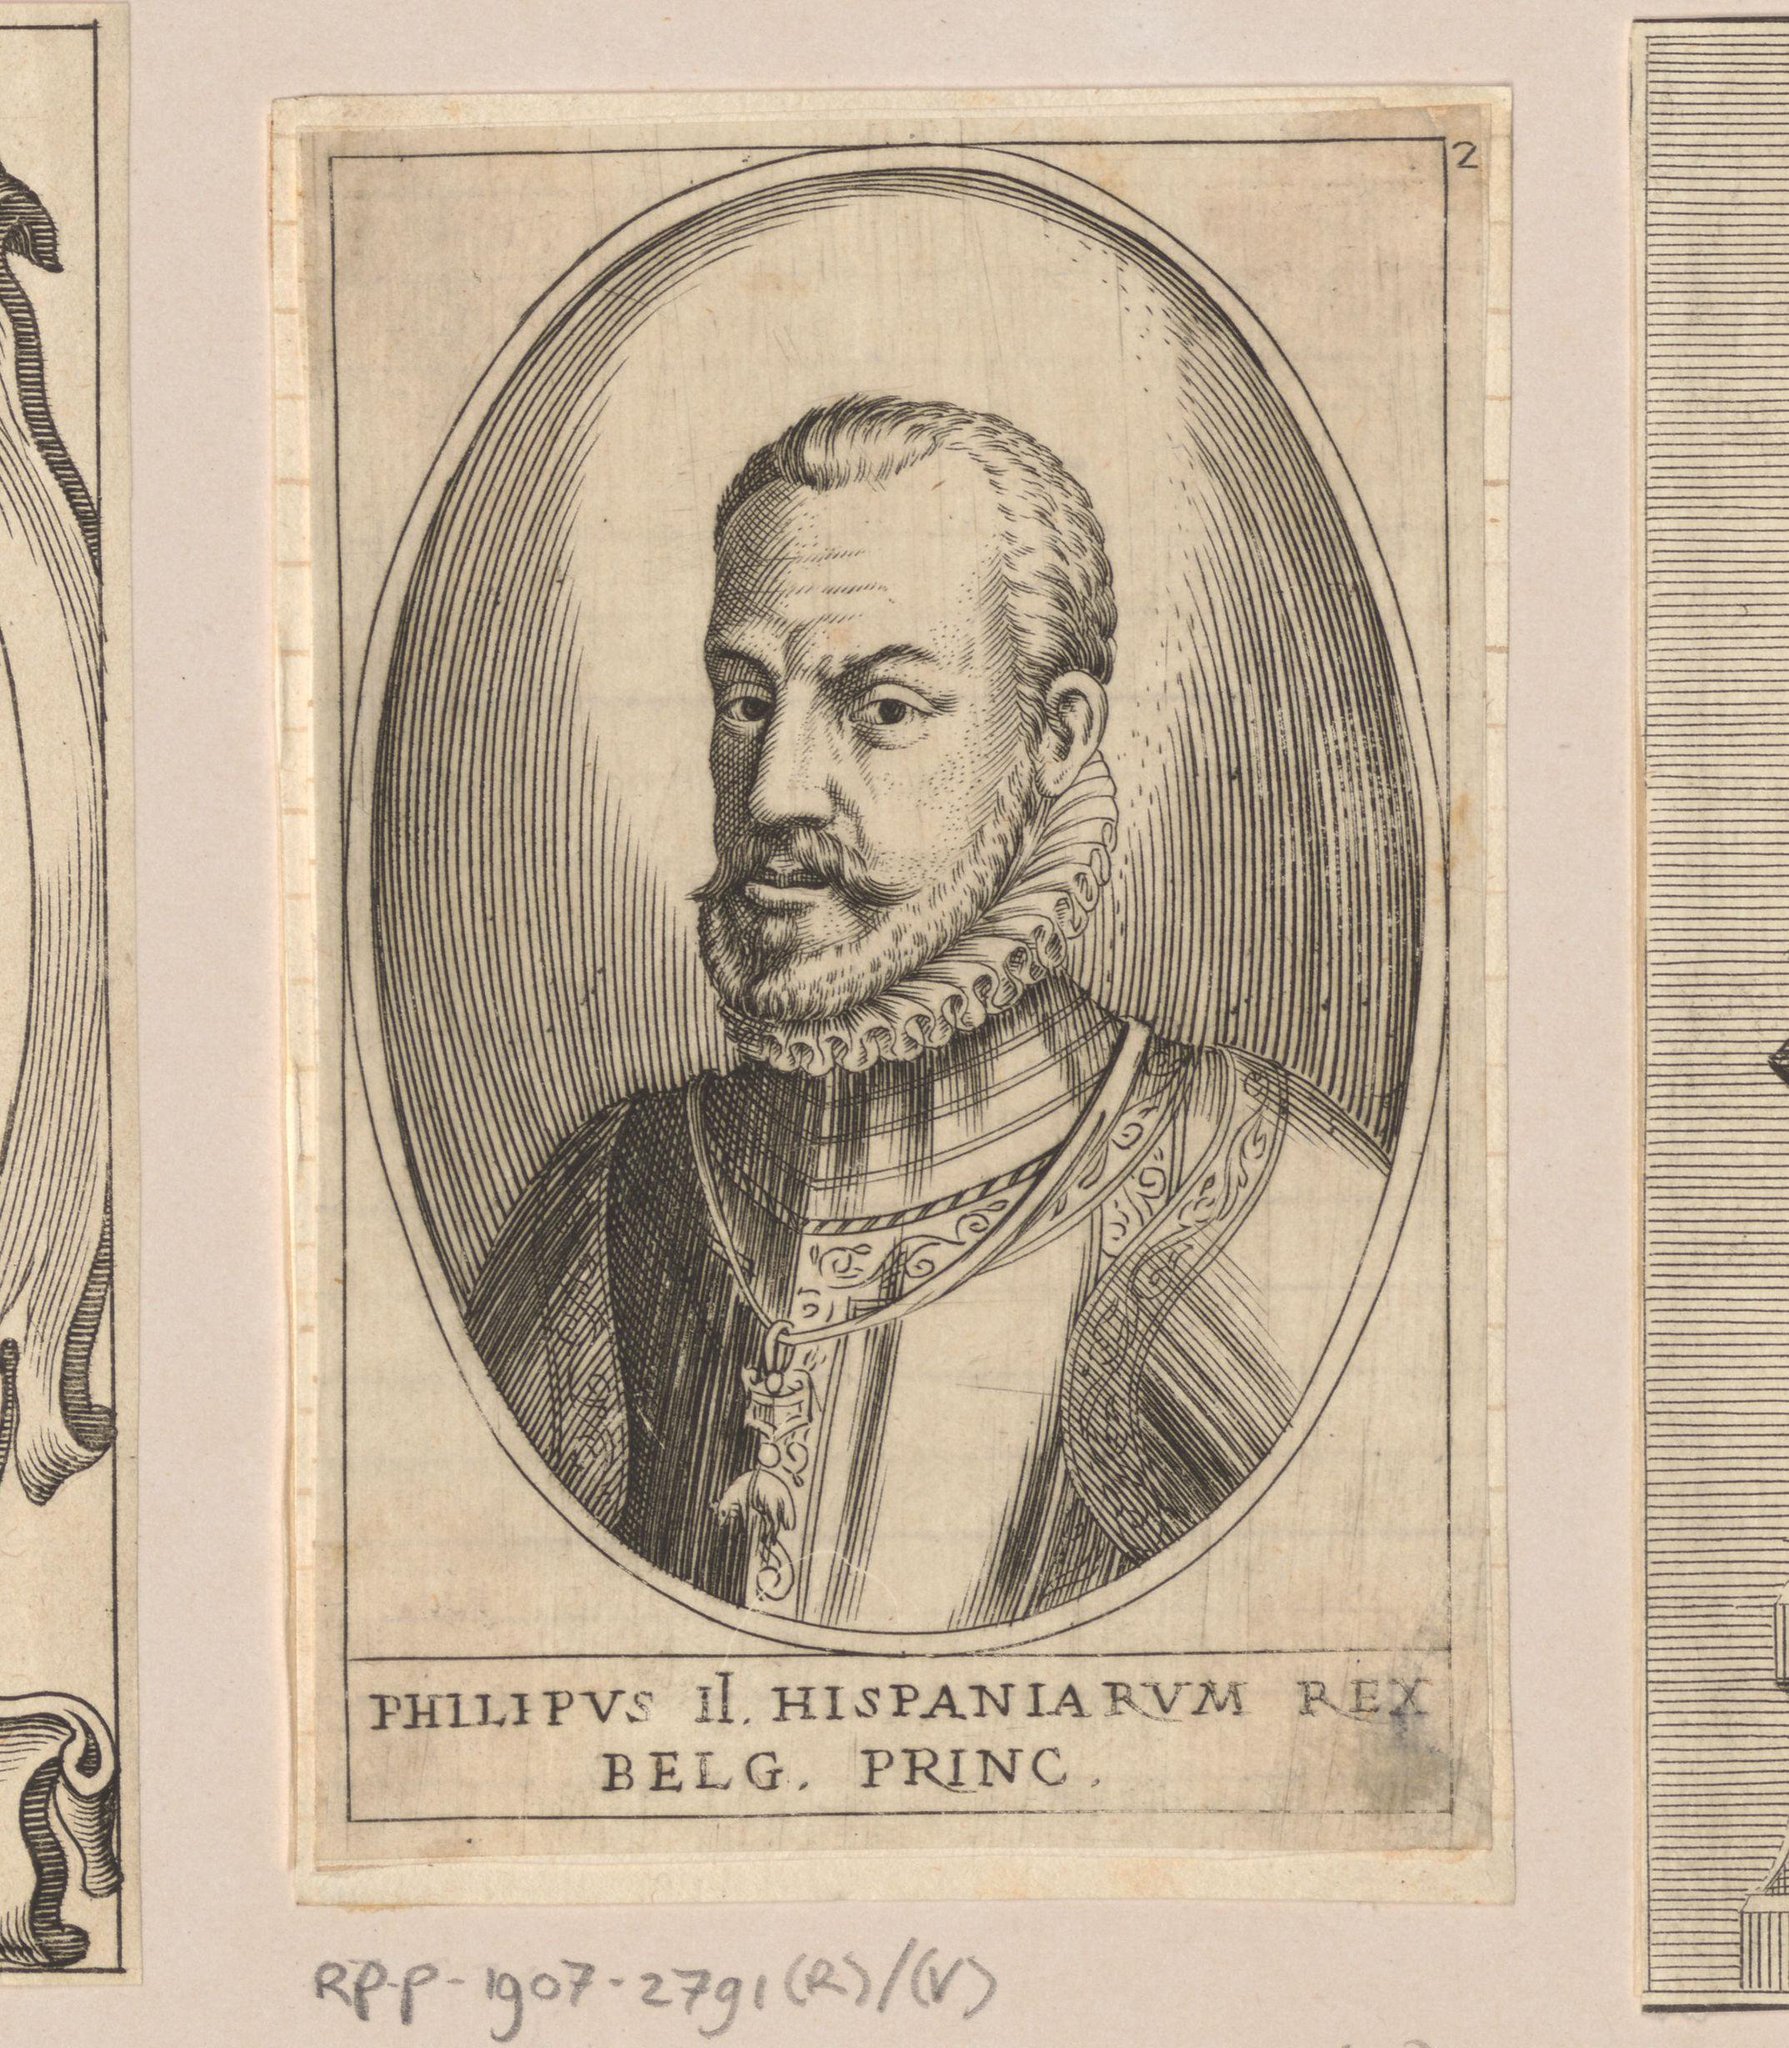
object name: print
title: Portret van Filips II, koning van Spanje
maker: Anonymous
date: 1625-1699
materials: paper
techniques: engraving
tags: philip ii of spain, adult man, historical persons, knighthood order of the golden fleece